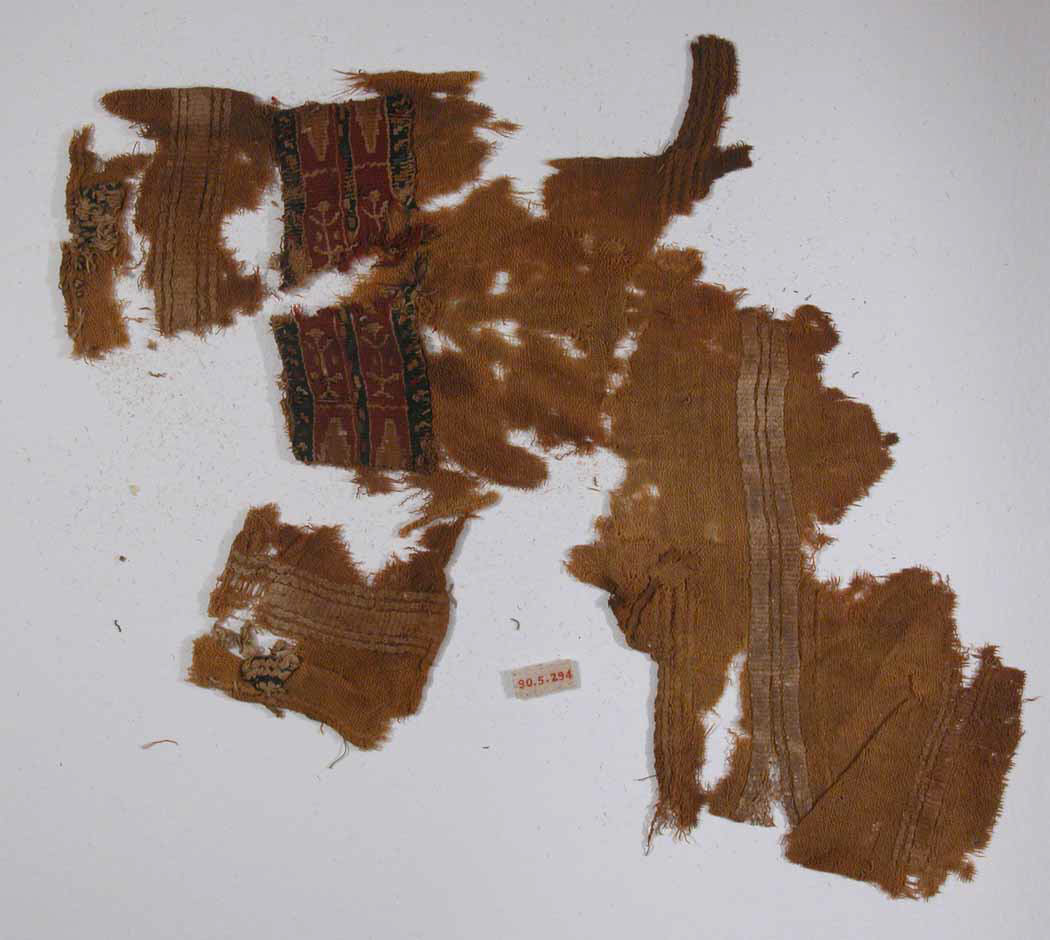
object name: textile fragment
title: Fragment of a Sleeve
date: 401-600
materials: linen, wool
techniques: weave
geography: egypt